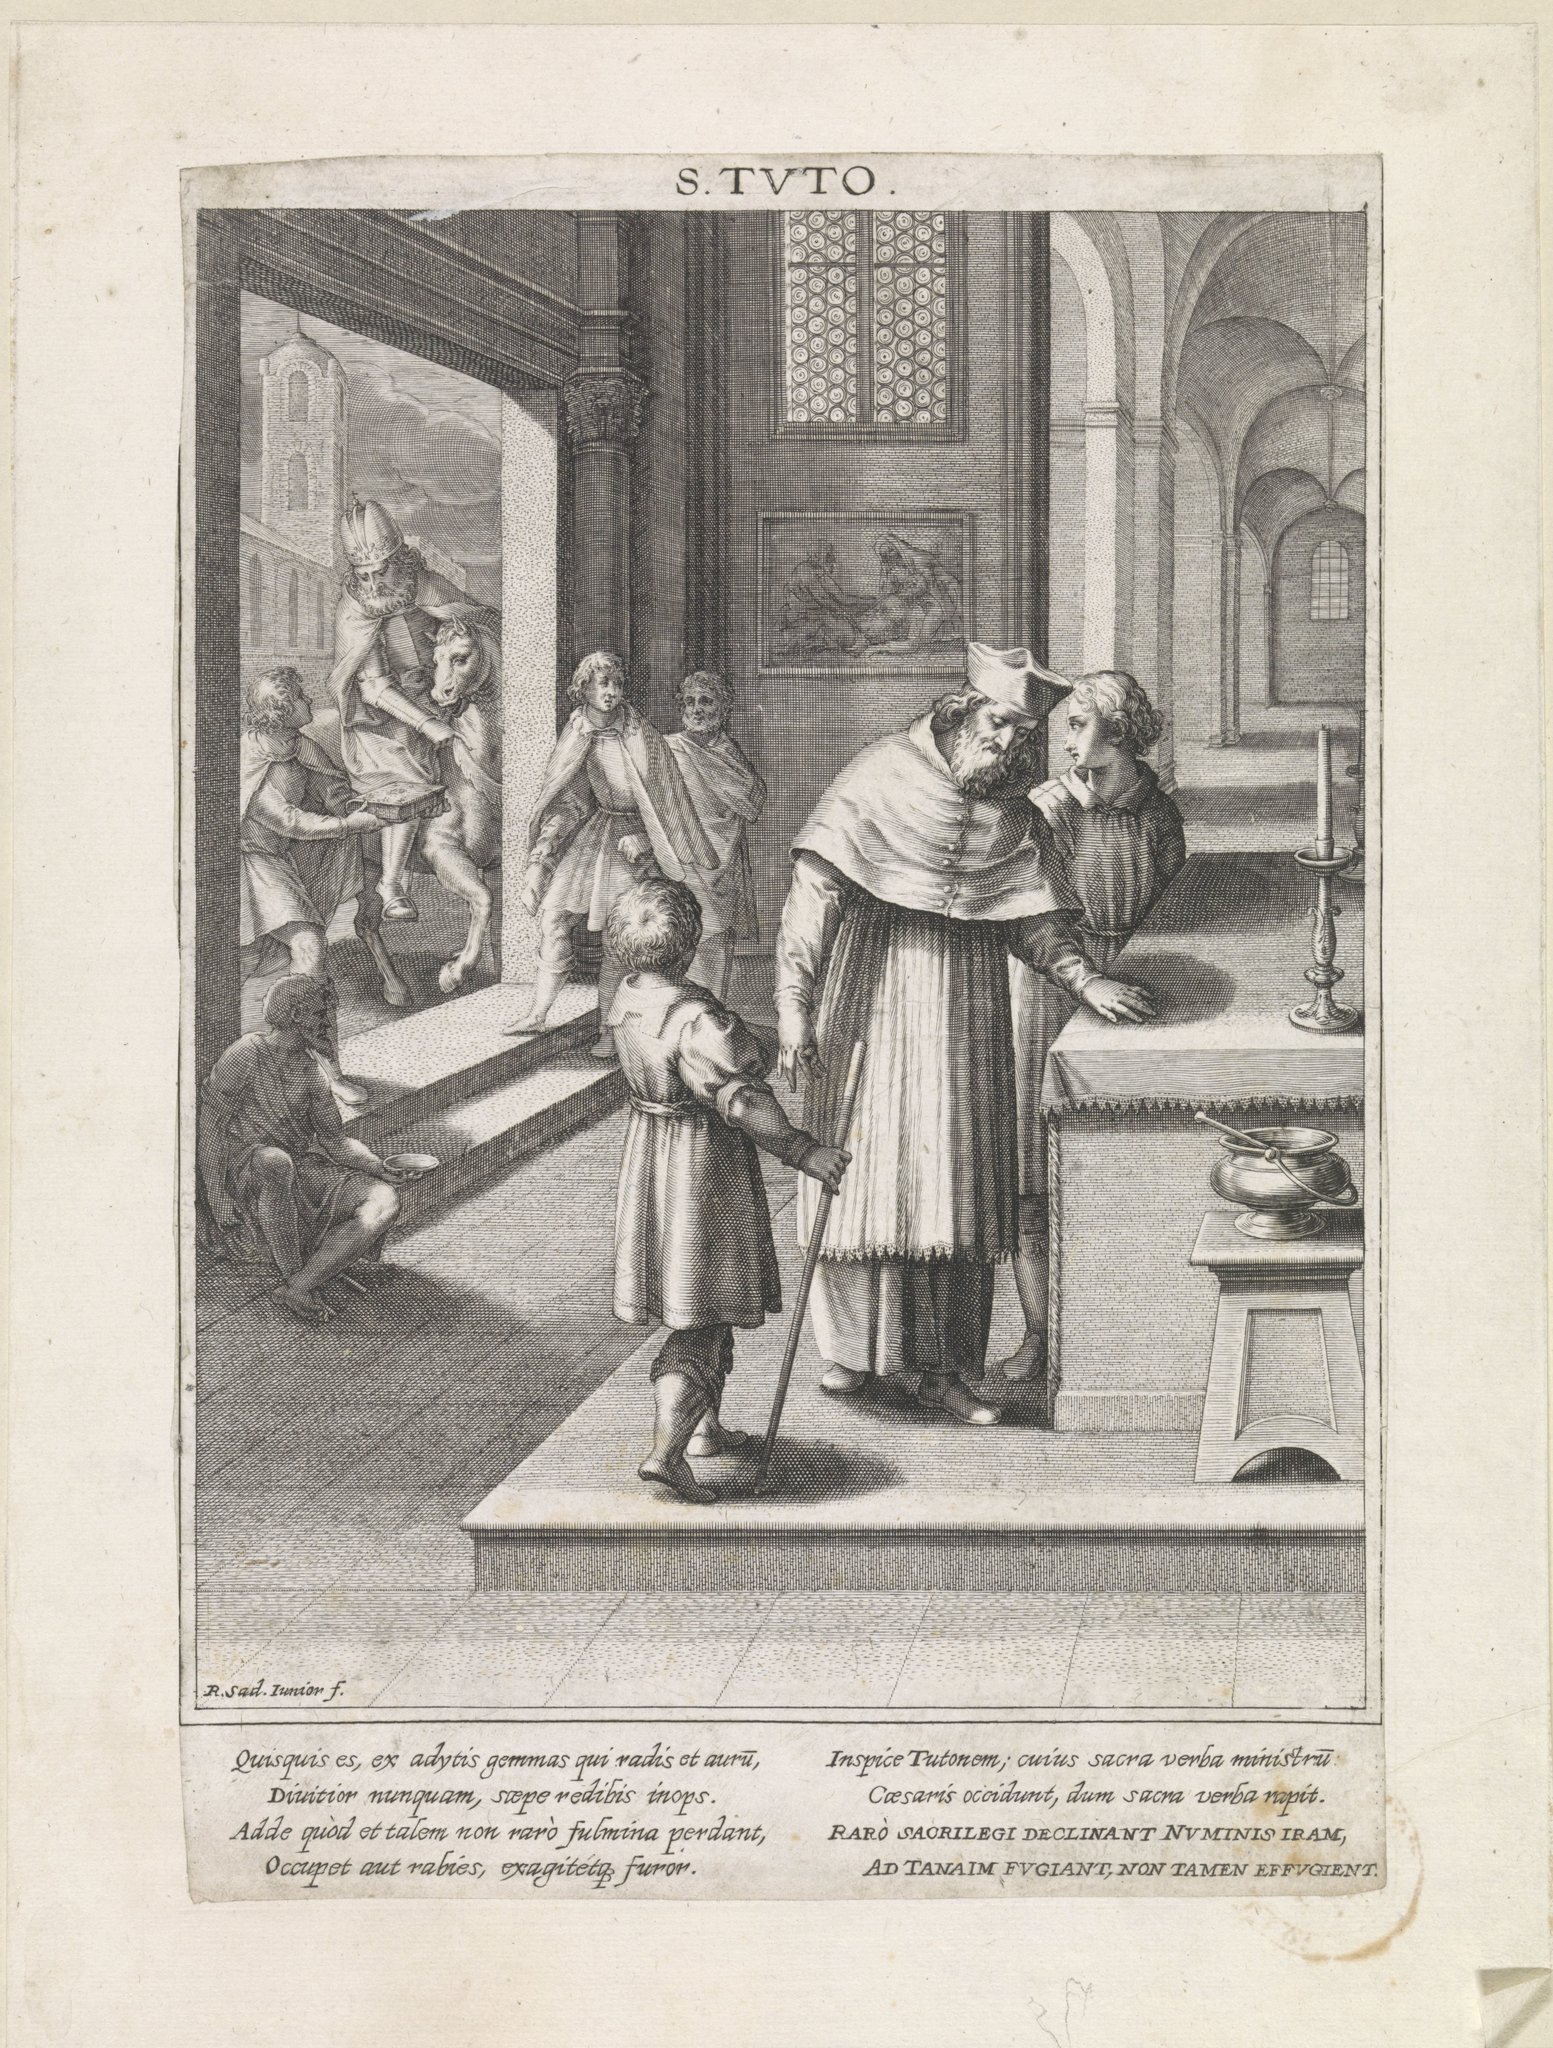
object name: print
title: Zalige Tutto van Regensburg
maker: raphaël sadeler (ii)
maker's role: print maker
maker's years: 1584-1632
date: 1627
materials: paper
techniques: engraving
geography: munich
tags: codex, male saints (with name), archbishop, bishop, etc. (roman catholic), emperor, altar, the bible as a book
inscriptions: collector's mark: Lugt 240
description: Z. Tutto, de blinde abt-bisschop van Regensburg, staat samen met twee jongens voor het altaar van een kerk. Links op de achtergrond keizer Arnulf van Karinthië op een paard. Hij stuurt een dienaar de kerk binnen om de Z. Tutto de Codex Aureus aan te bieden. De prent heeft een Latijns onderschrift.